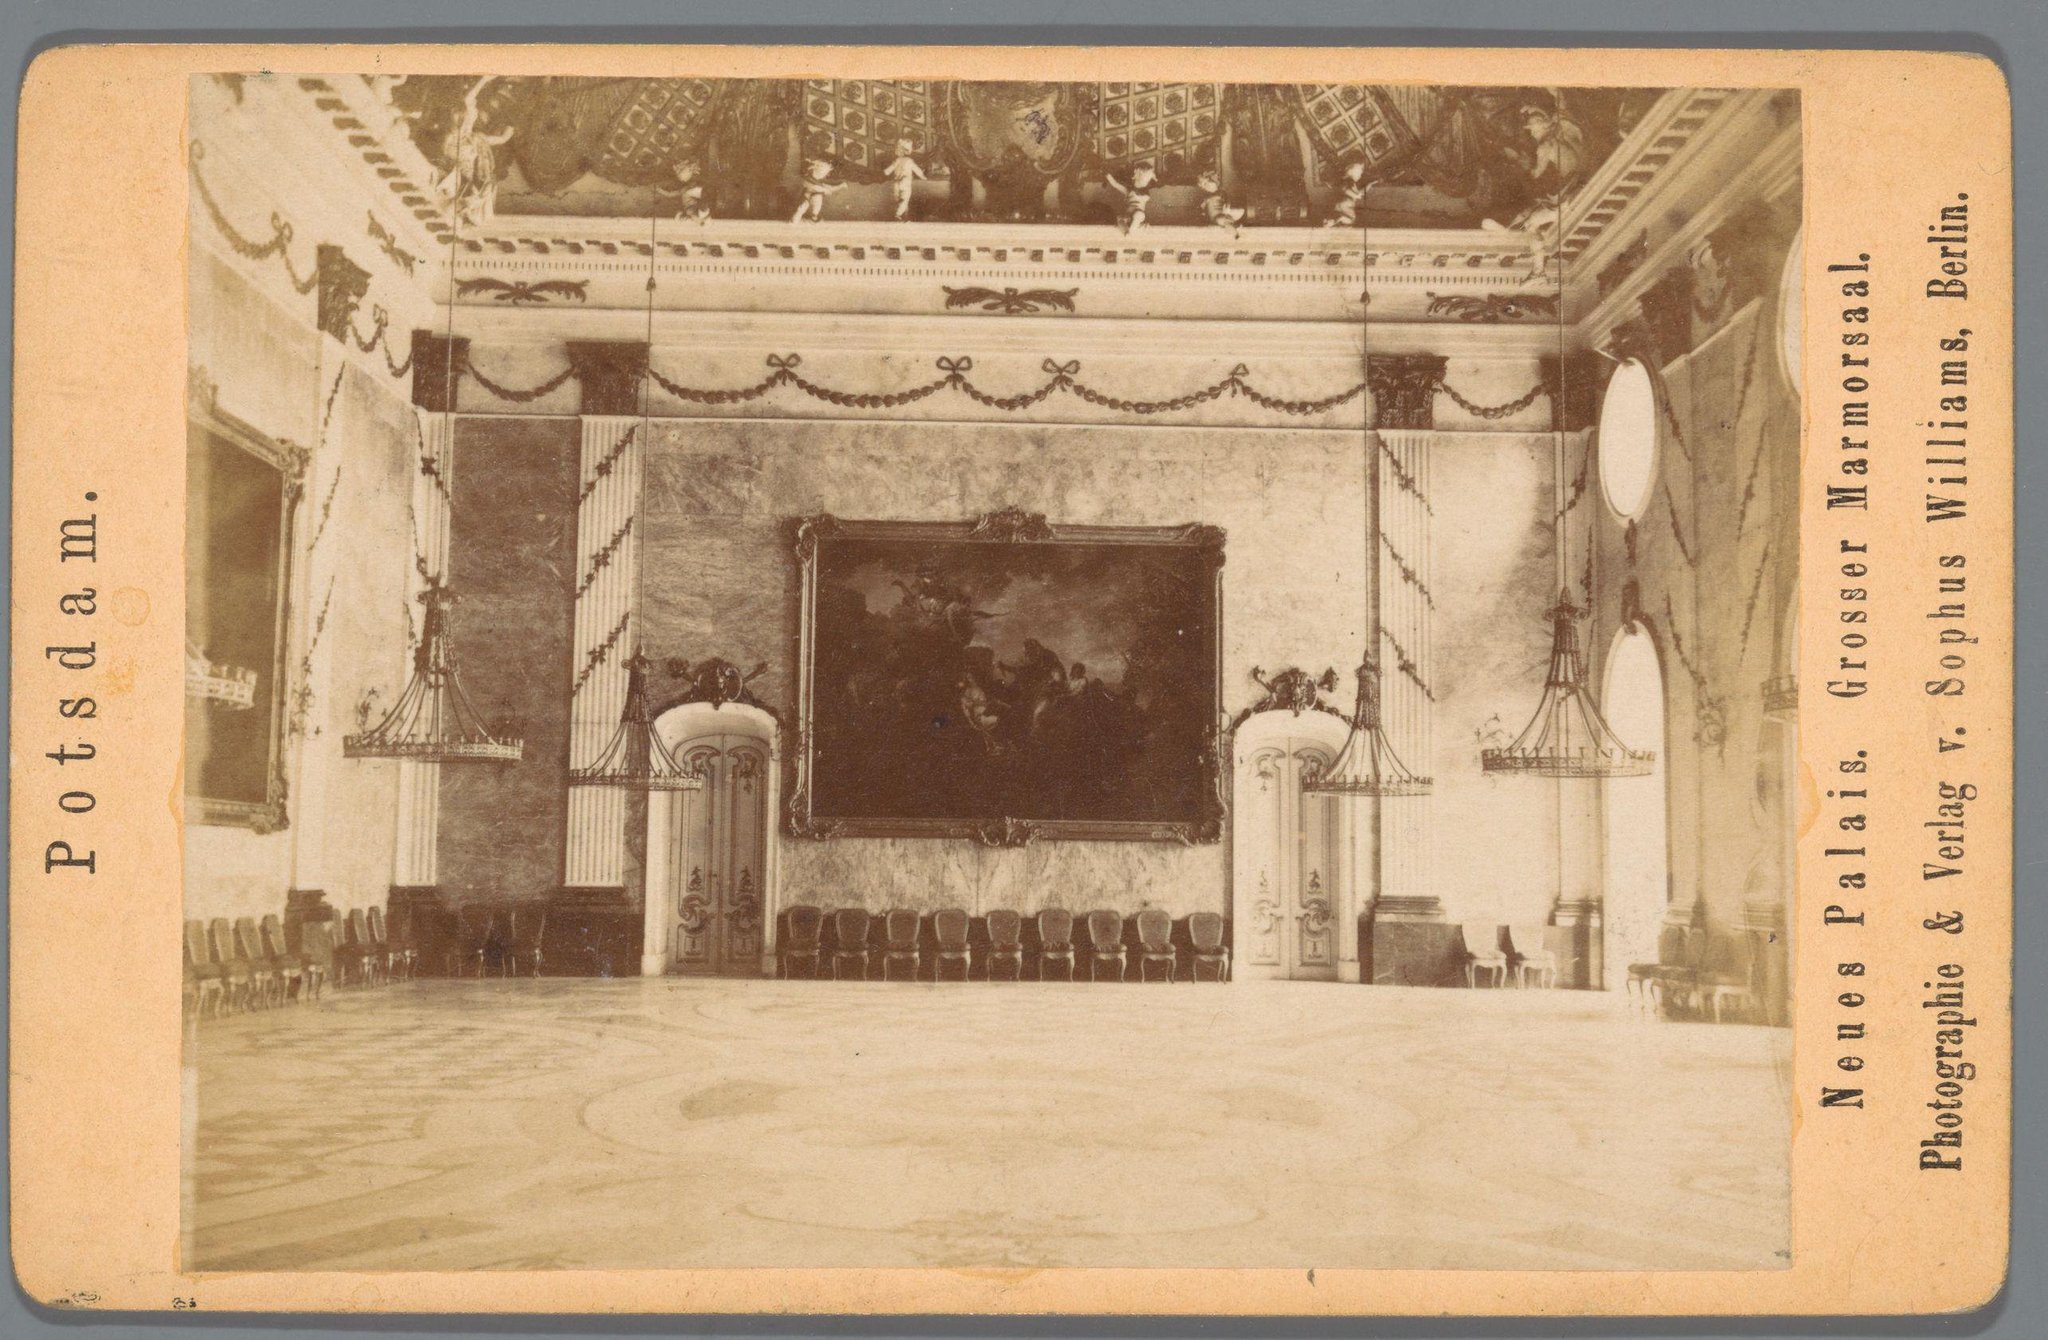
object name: carte de visite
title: Marmerzaal in het Neues Palais, Potsdam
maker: sophus williams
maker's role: publisher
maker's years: 1835-1900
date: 1855-1885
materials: cardboard, paper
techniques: albumen print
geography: potsdam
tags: palace - aa - civic architecture: inside